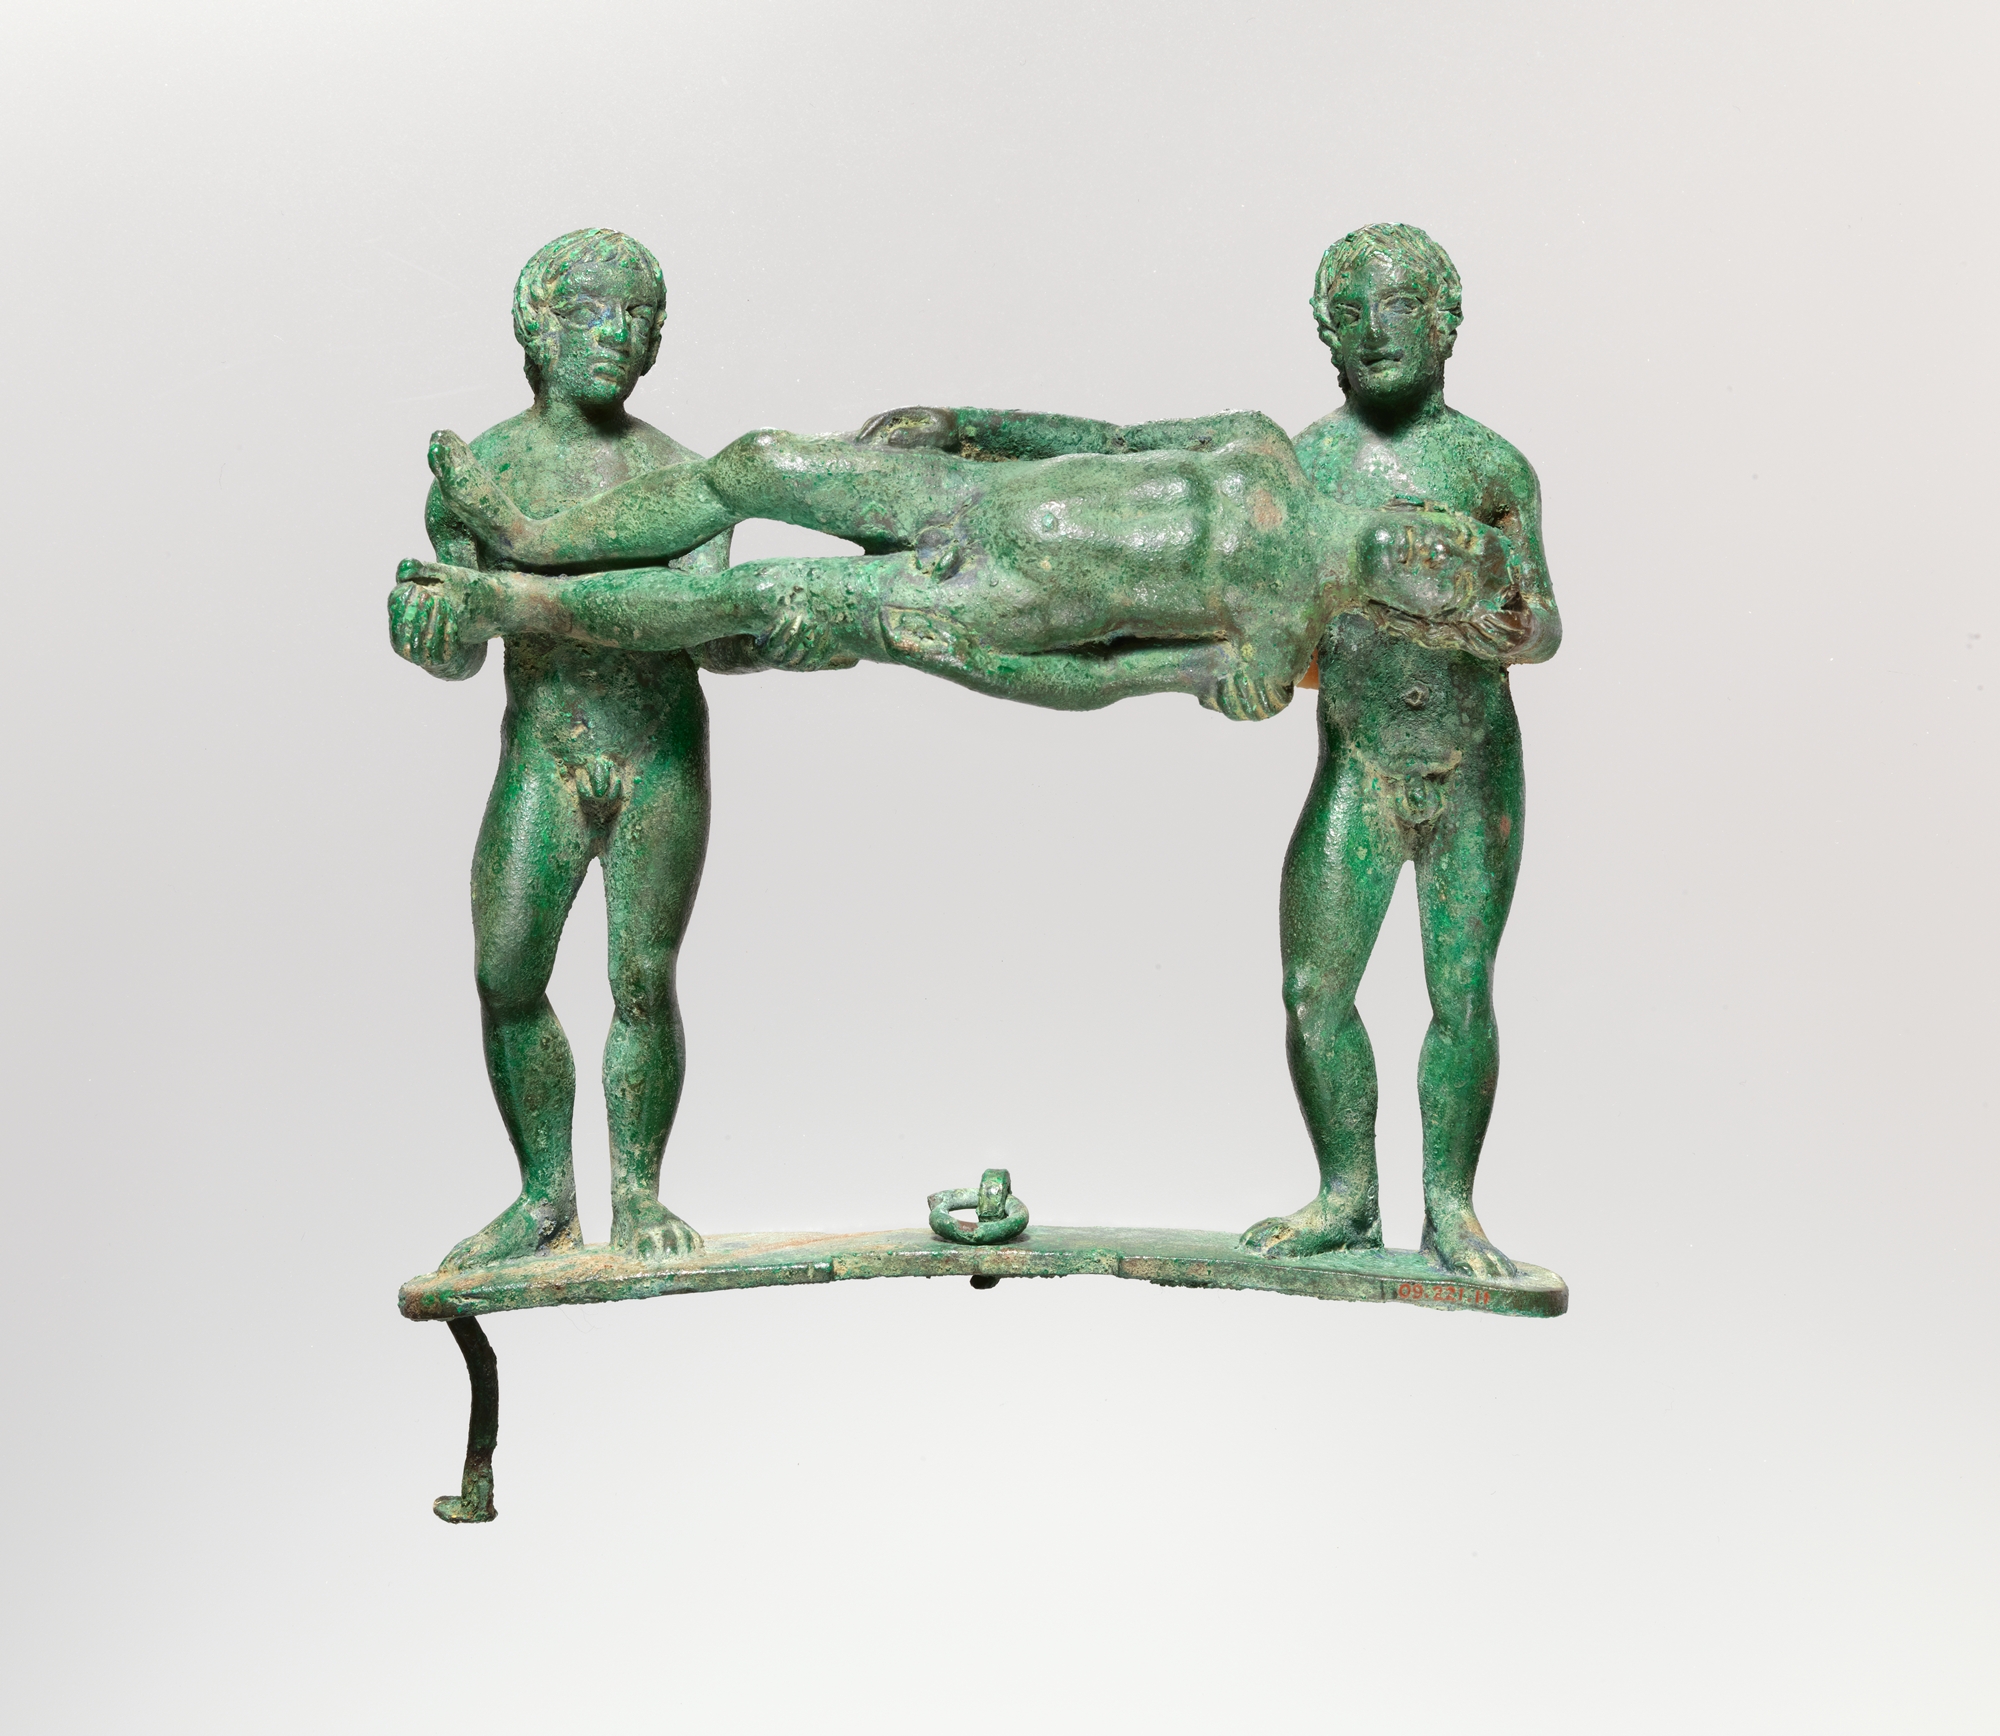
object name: handle of a cista with youth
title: Bronze handle from a cista (toiletry box)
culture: praenestine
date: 400-301 BCE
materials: bronze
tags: male nudes